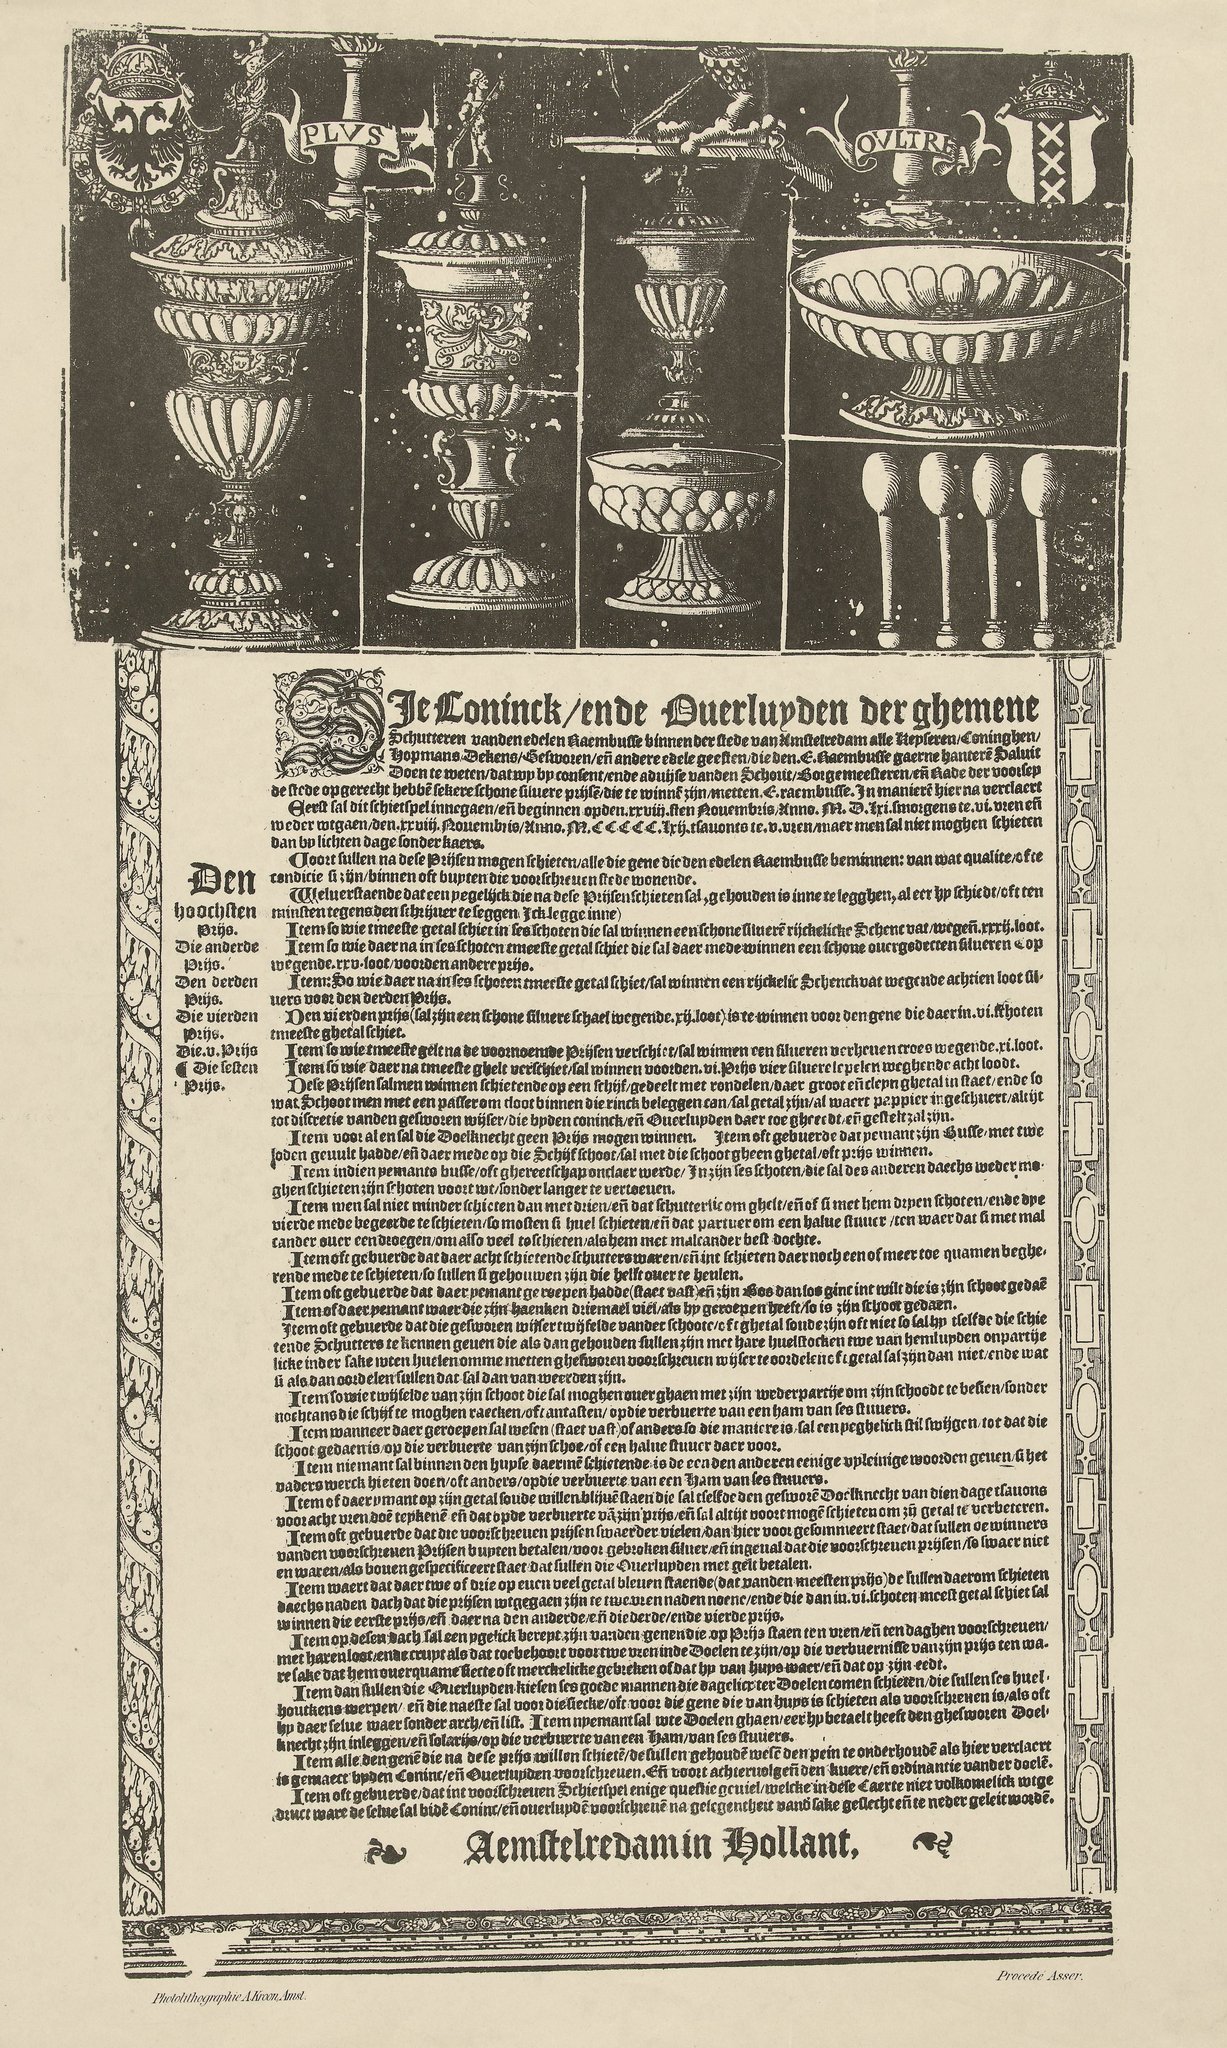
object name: print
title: Prijzen te winnen bij een wedstrijd kruisboogschieten, 1561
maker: a. kroon (fotograaf)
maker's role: fotograaf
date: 1879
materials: paper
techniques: photolithograph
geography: netherlands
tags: spoon, drinking-vessels, amsterdam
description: Aankoniging van een wedstrijd kruisboogschieten met een overzicht van de te winnen prijzen, georganiseerd door de schutterij met de Raambusse te Amsterdam, 1561. Zilveren pronkbekers, schalen en lepels.